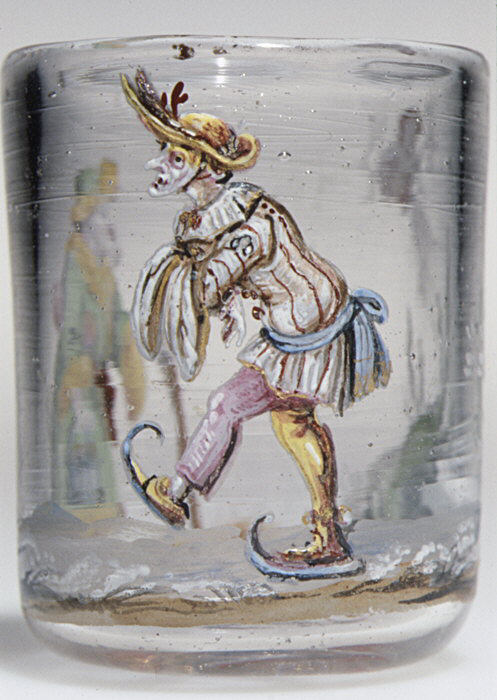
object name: schnapps glass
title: Schnapps glass (one of twelve)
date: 1750-1775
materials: enamel, glass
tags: men